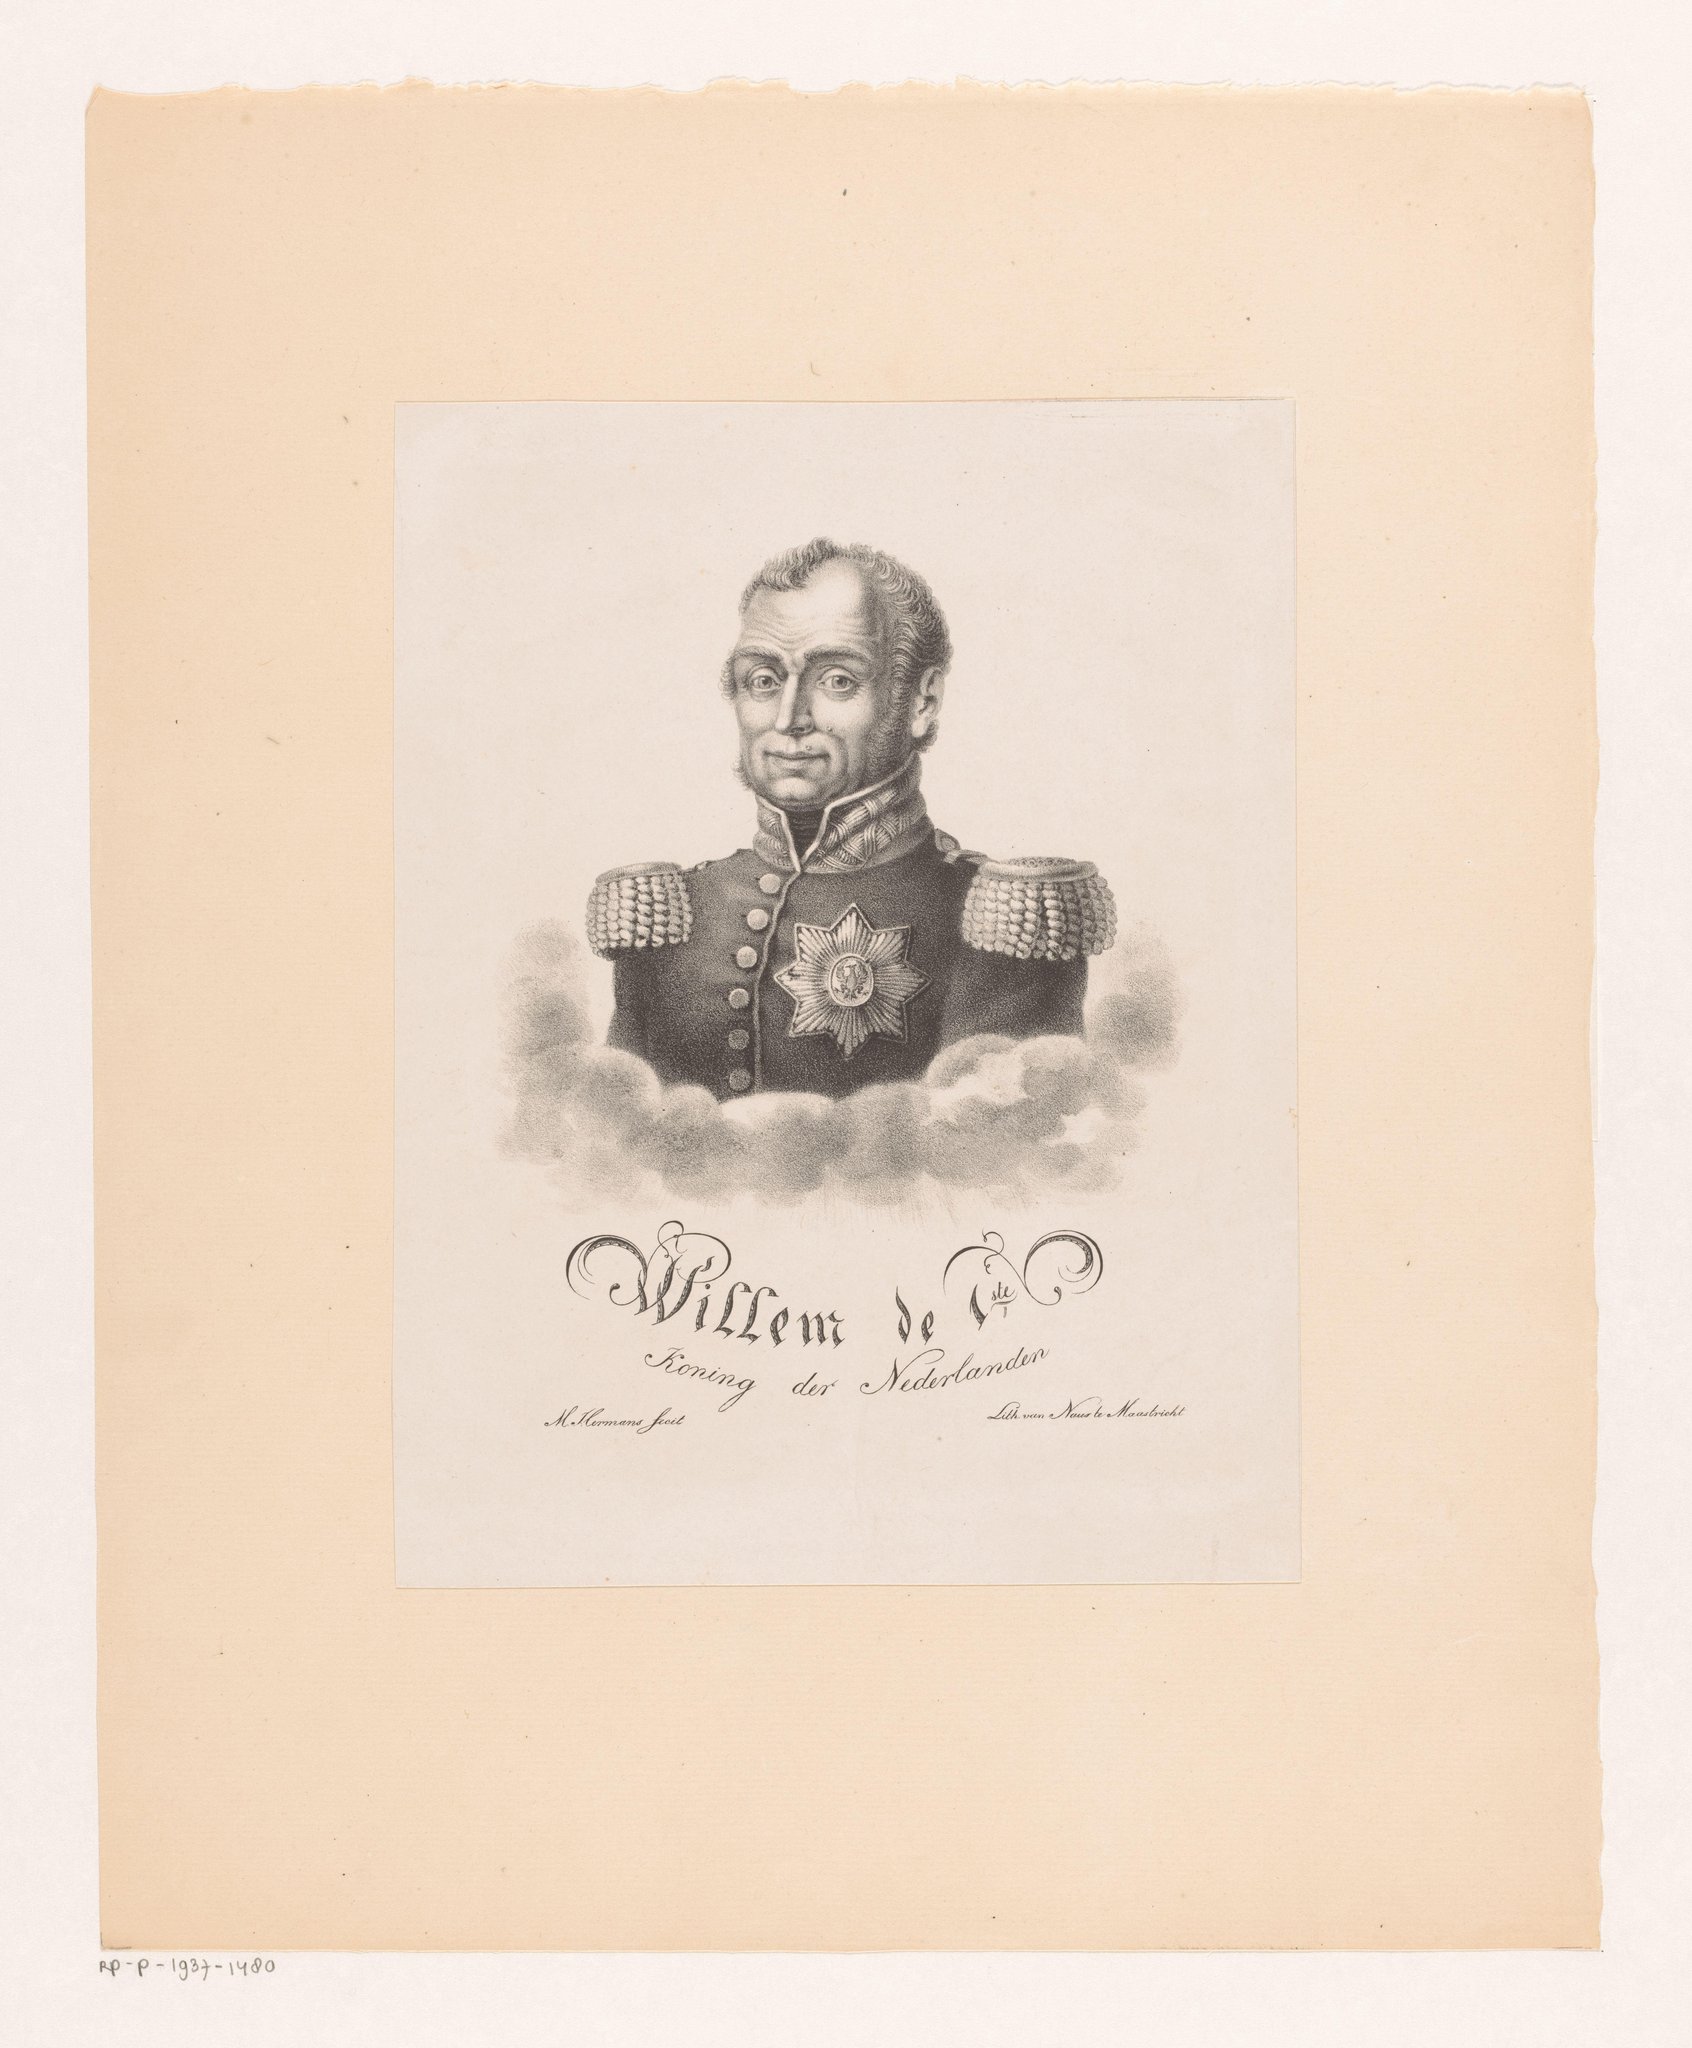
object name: print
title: Portret van Koning Willem I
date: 1809-1842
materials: paper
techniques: lithograph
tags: the hague, berlin, william i of the netherlands, historical persons (+ (full) bust portrait)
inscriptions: collector's mark: Lugt 2760, collector's mark: Lugt 2228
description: De geportretteerde is afgebeeld tussen wolken. Hij draagt een militair kostuum met de Hoge Orde van de Zwarte Adelaar.